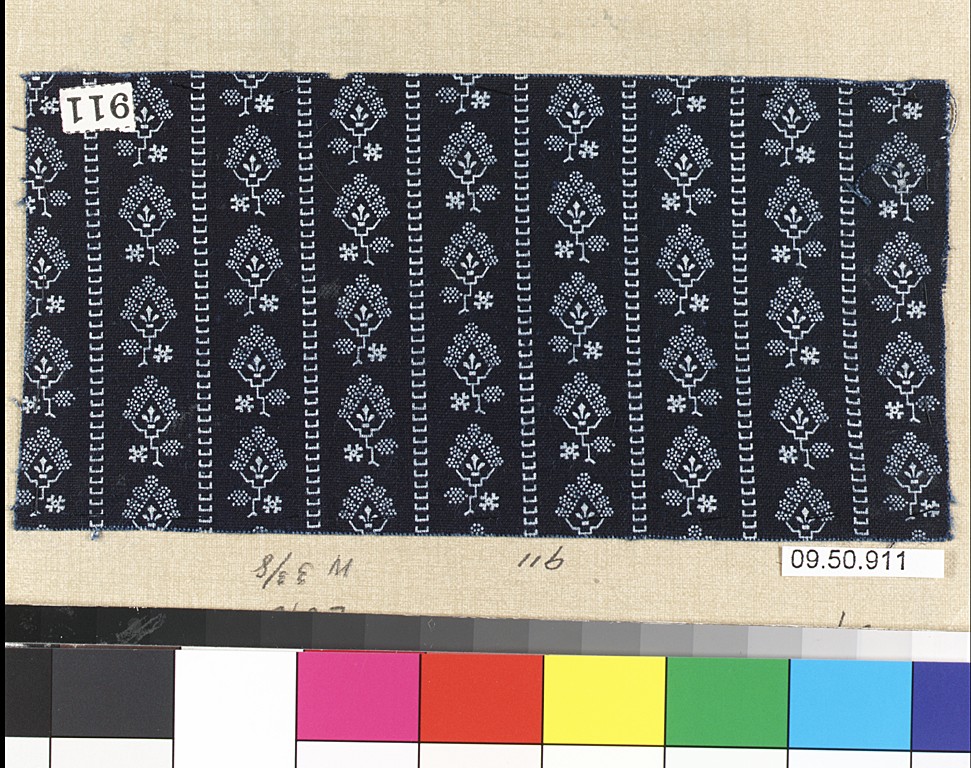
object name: piece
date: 1801-1900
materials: cotton